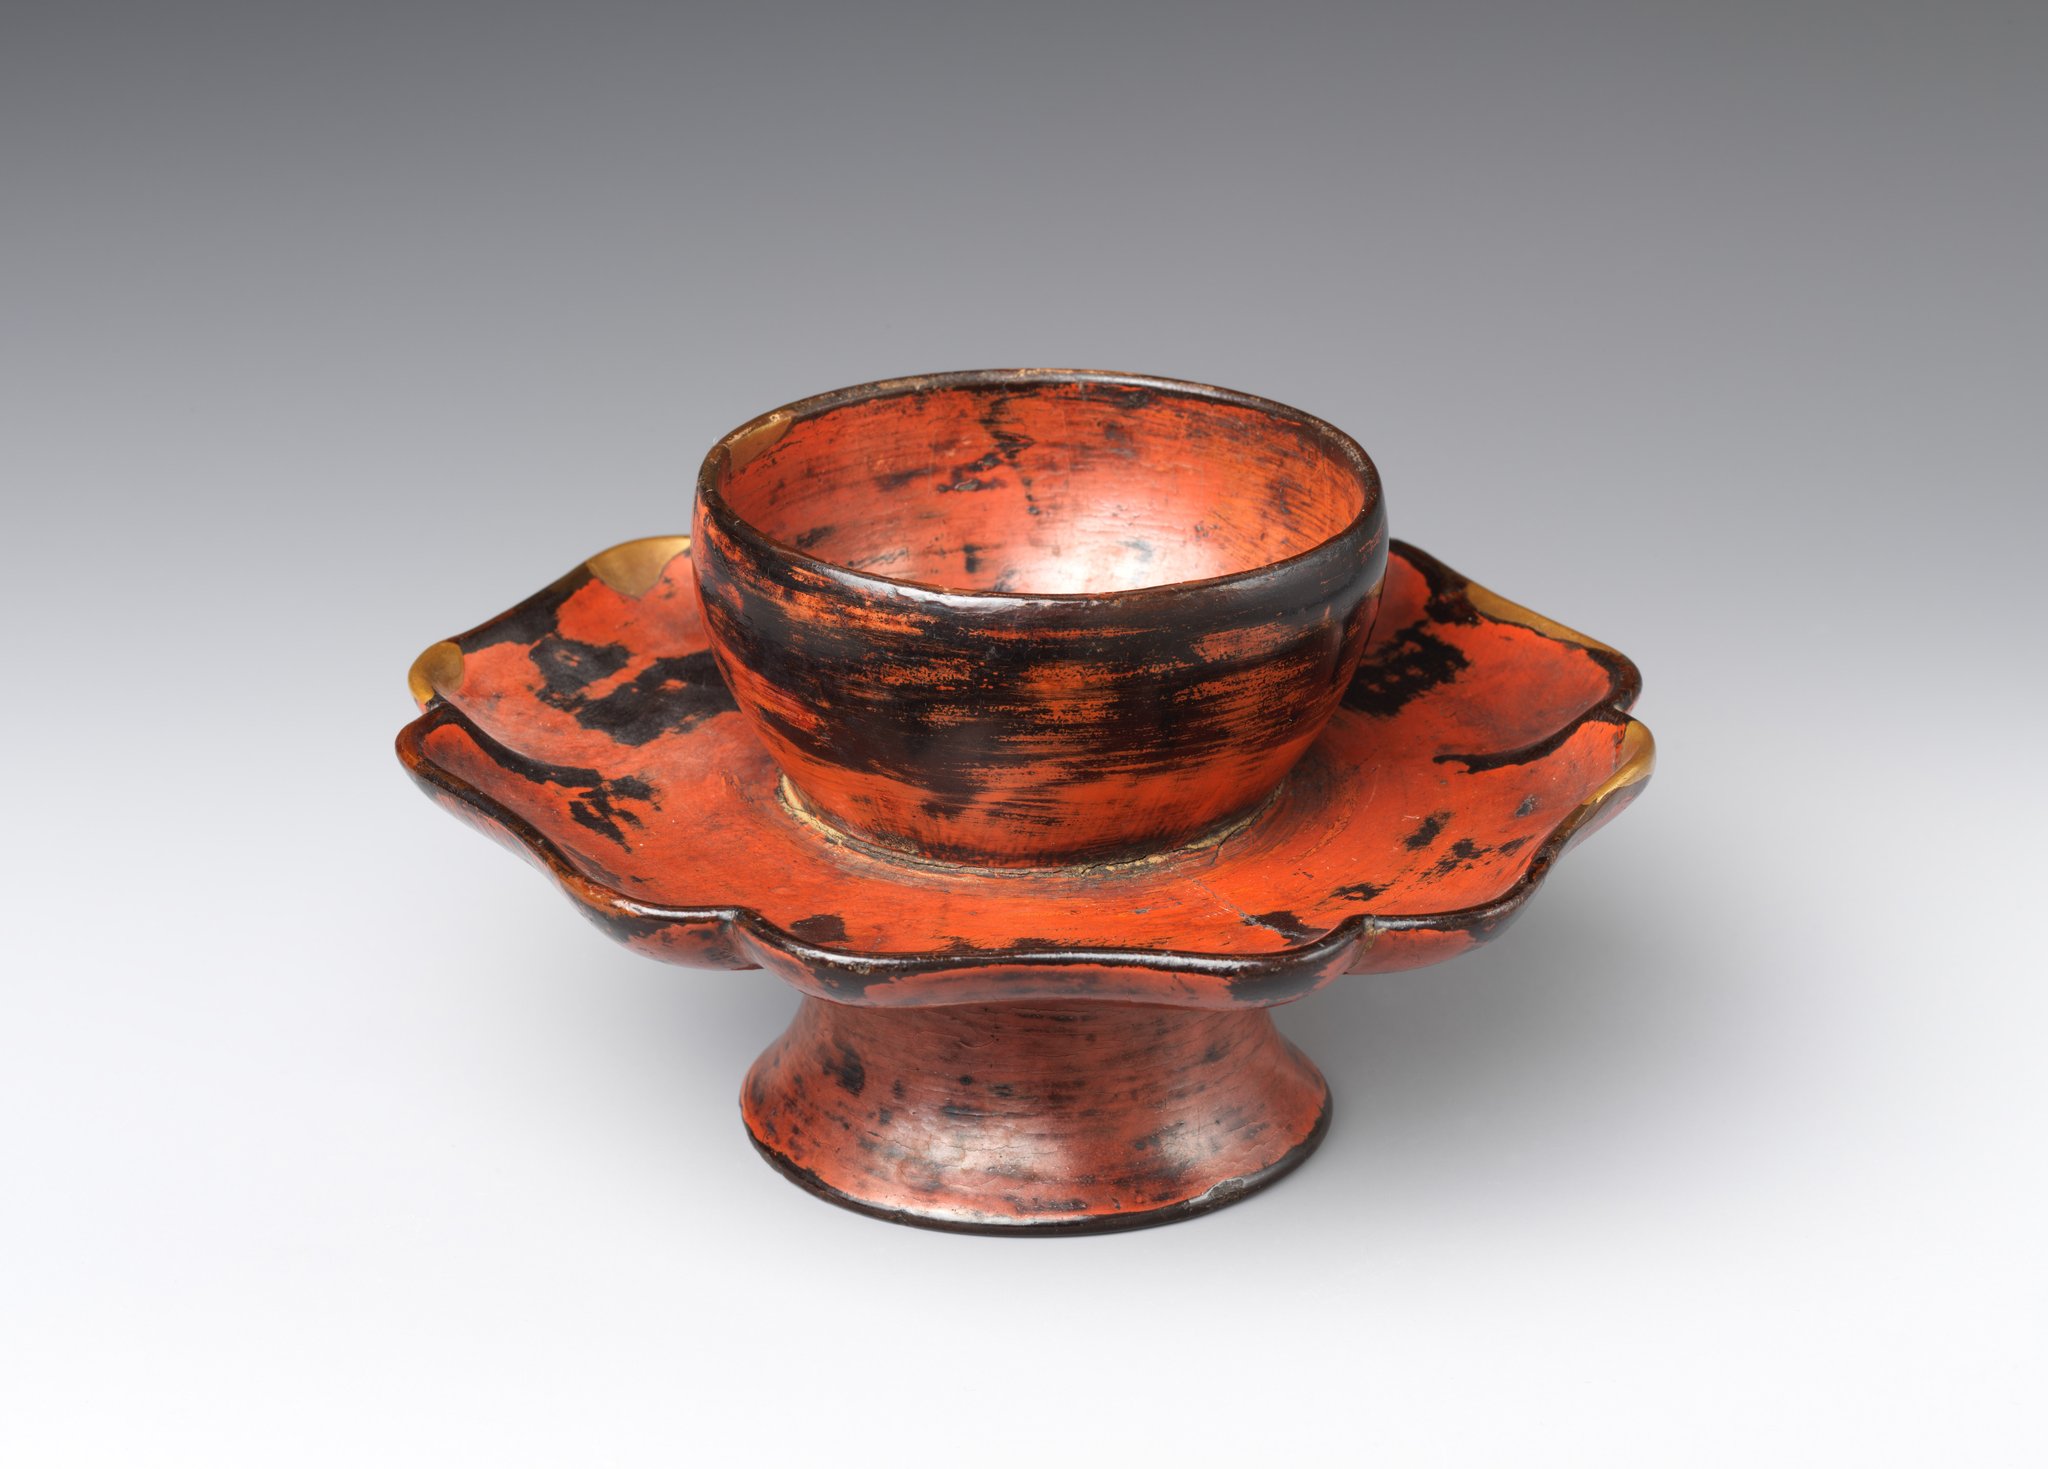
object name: stand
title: Stand for a Tenmoku Teabowl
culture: japanese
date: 1401-1600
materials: lacquer, wood